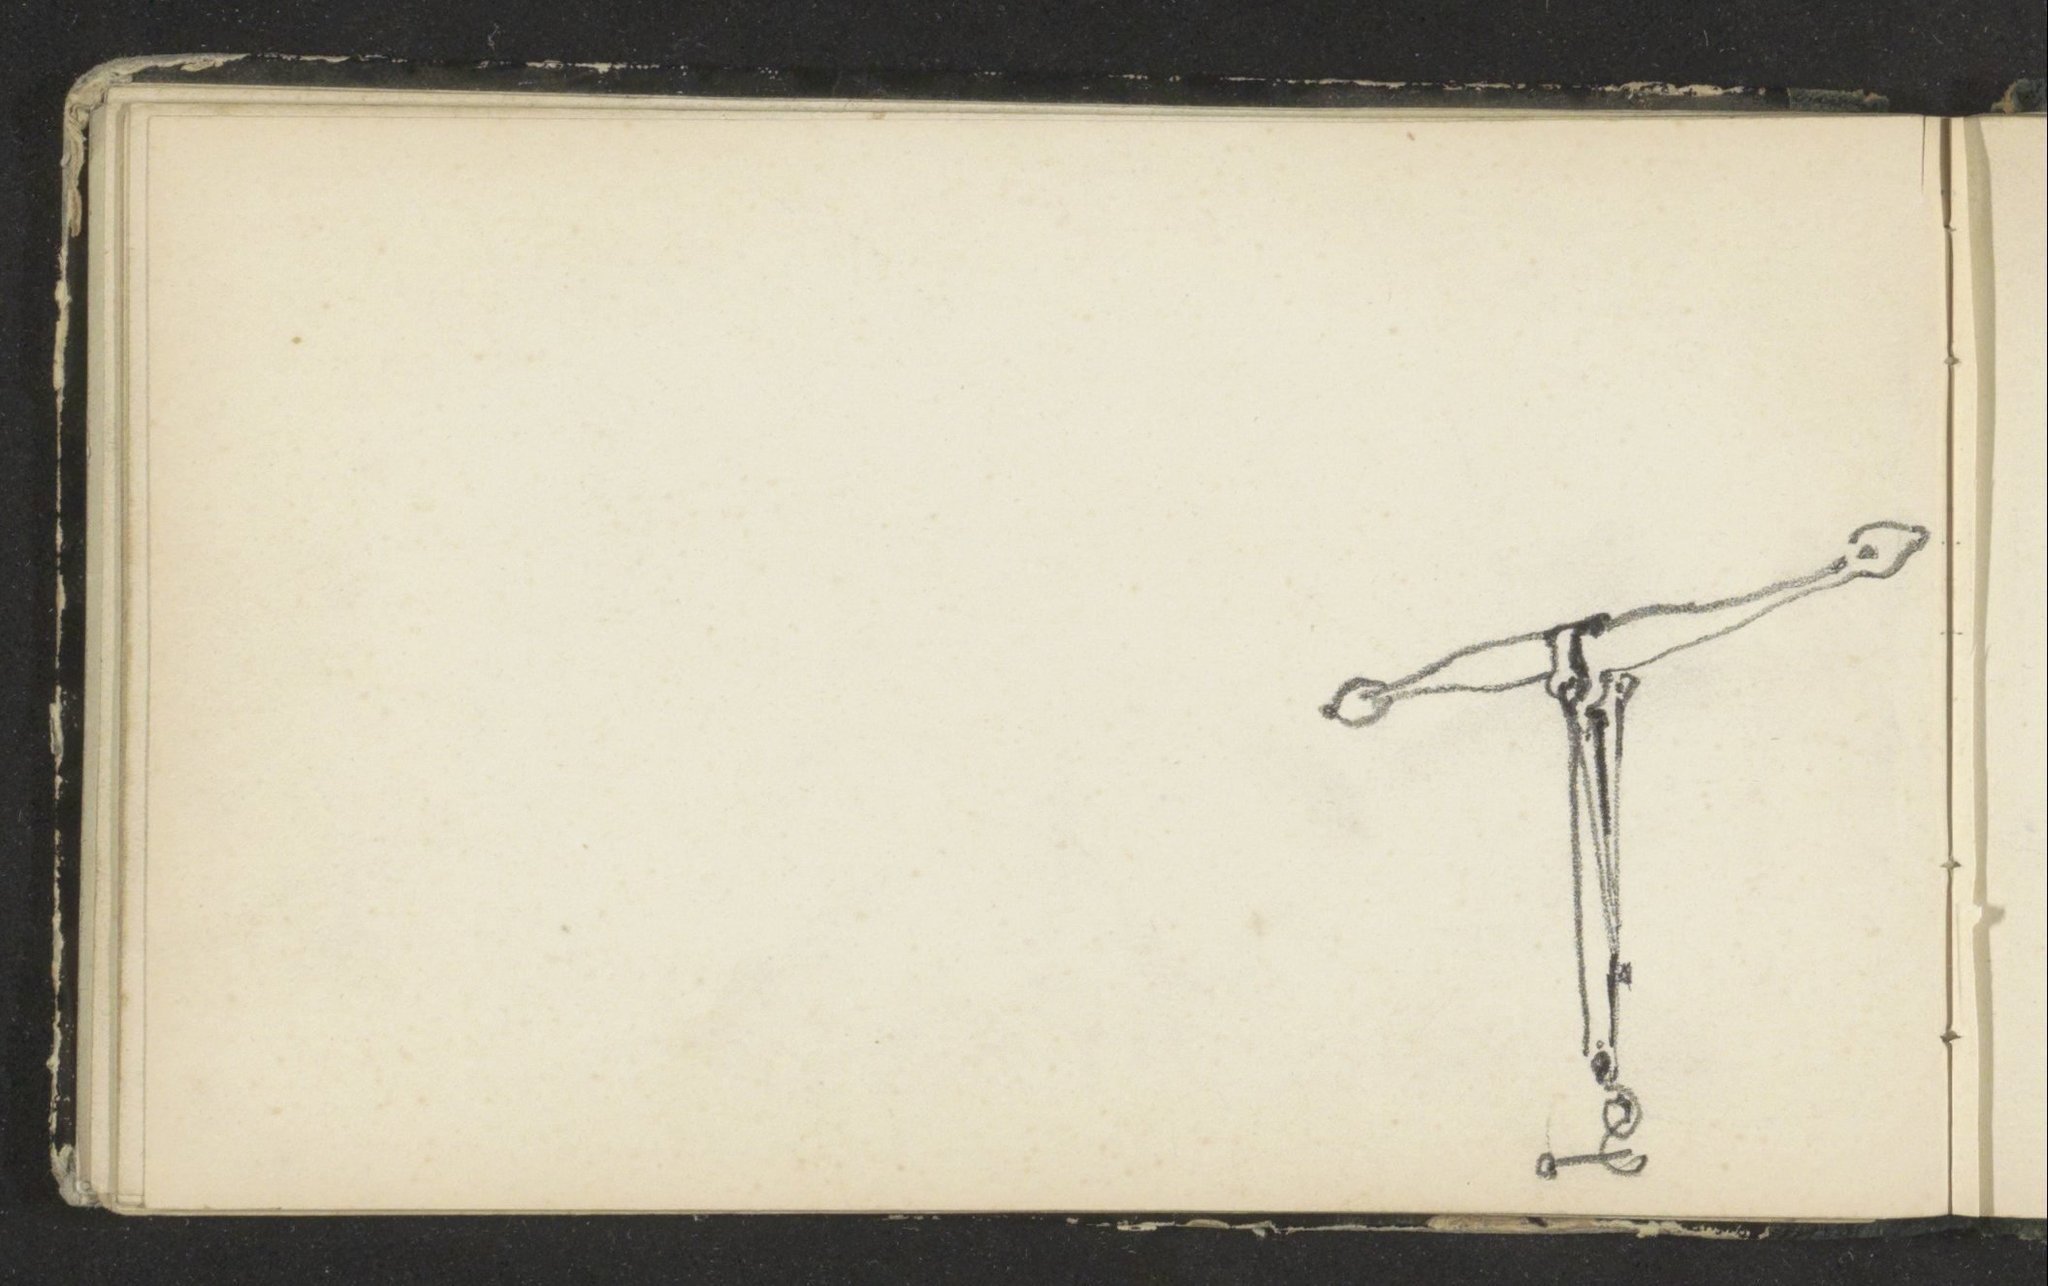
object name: sketchbook leaf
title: Voorwerp, mogelijk een deel van een weegschaal of -stok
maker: maria vos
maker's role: draughtsman, painter, print maker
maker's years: 1824-1906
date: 1834-1906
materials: paper, pencil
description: Blad 24 verso uit een schetsboek met 46 bladen.